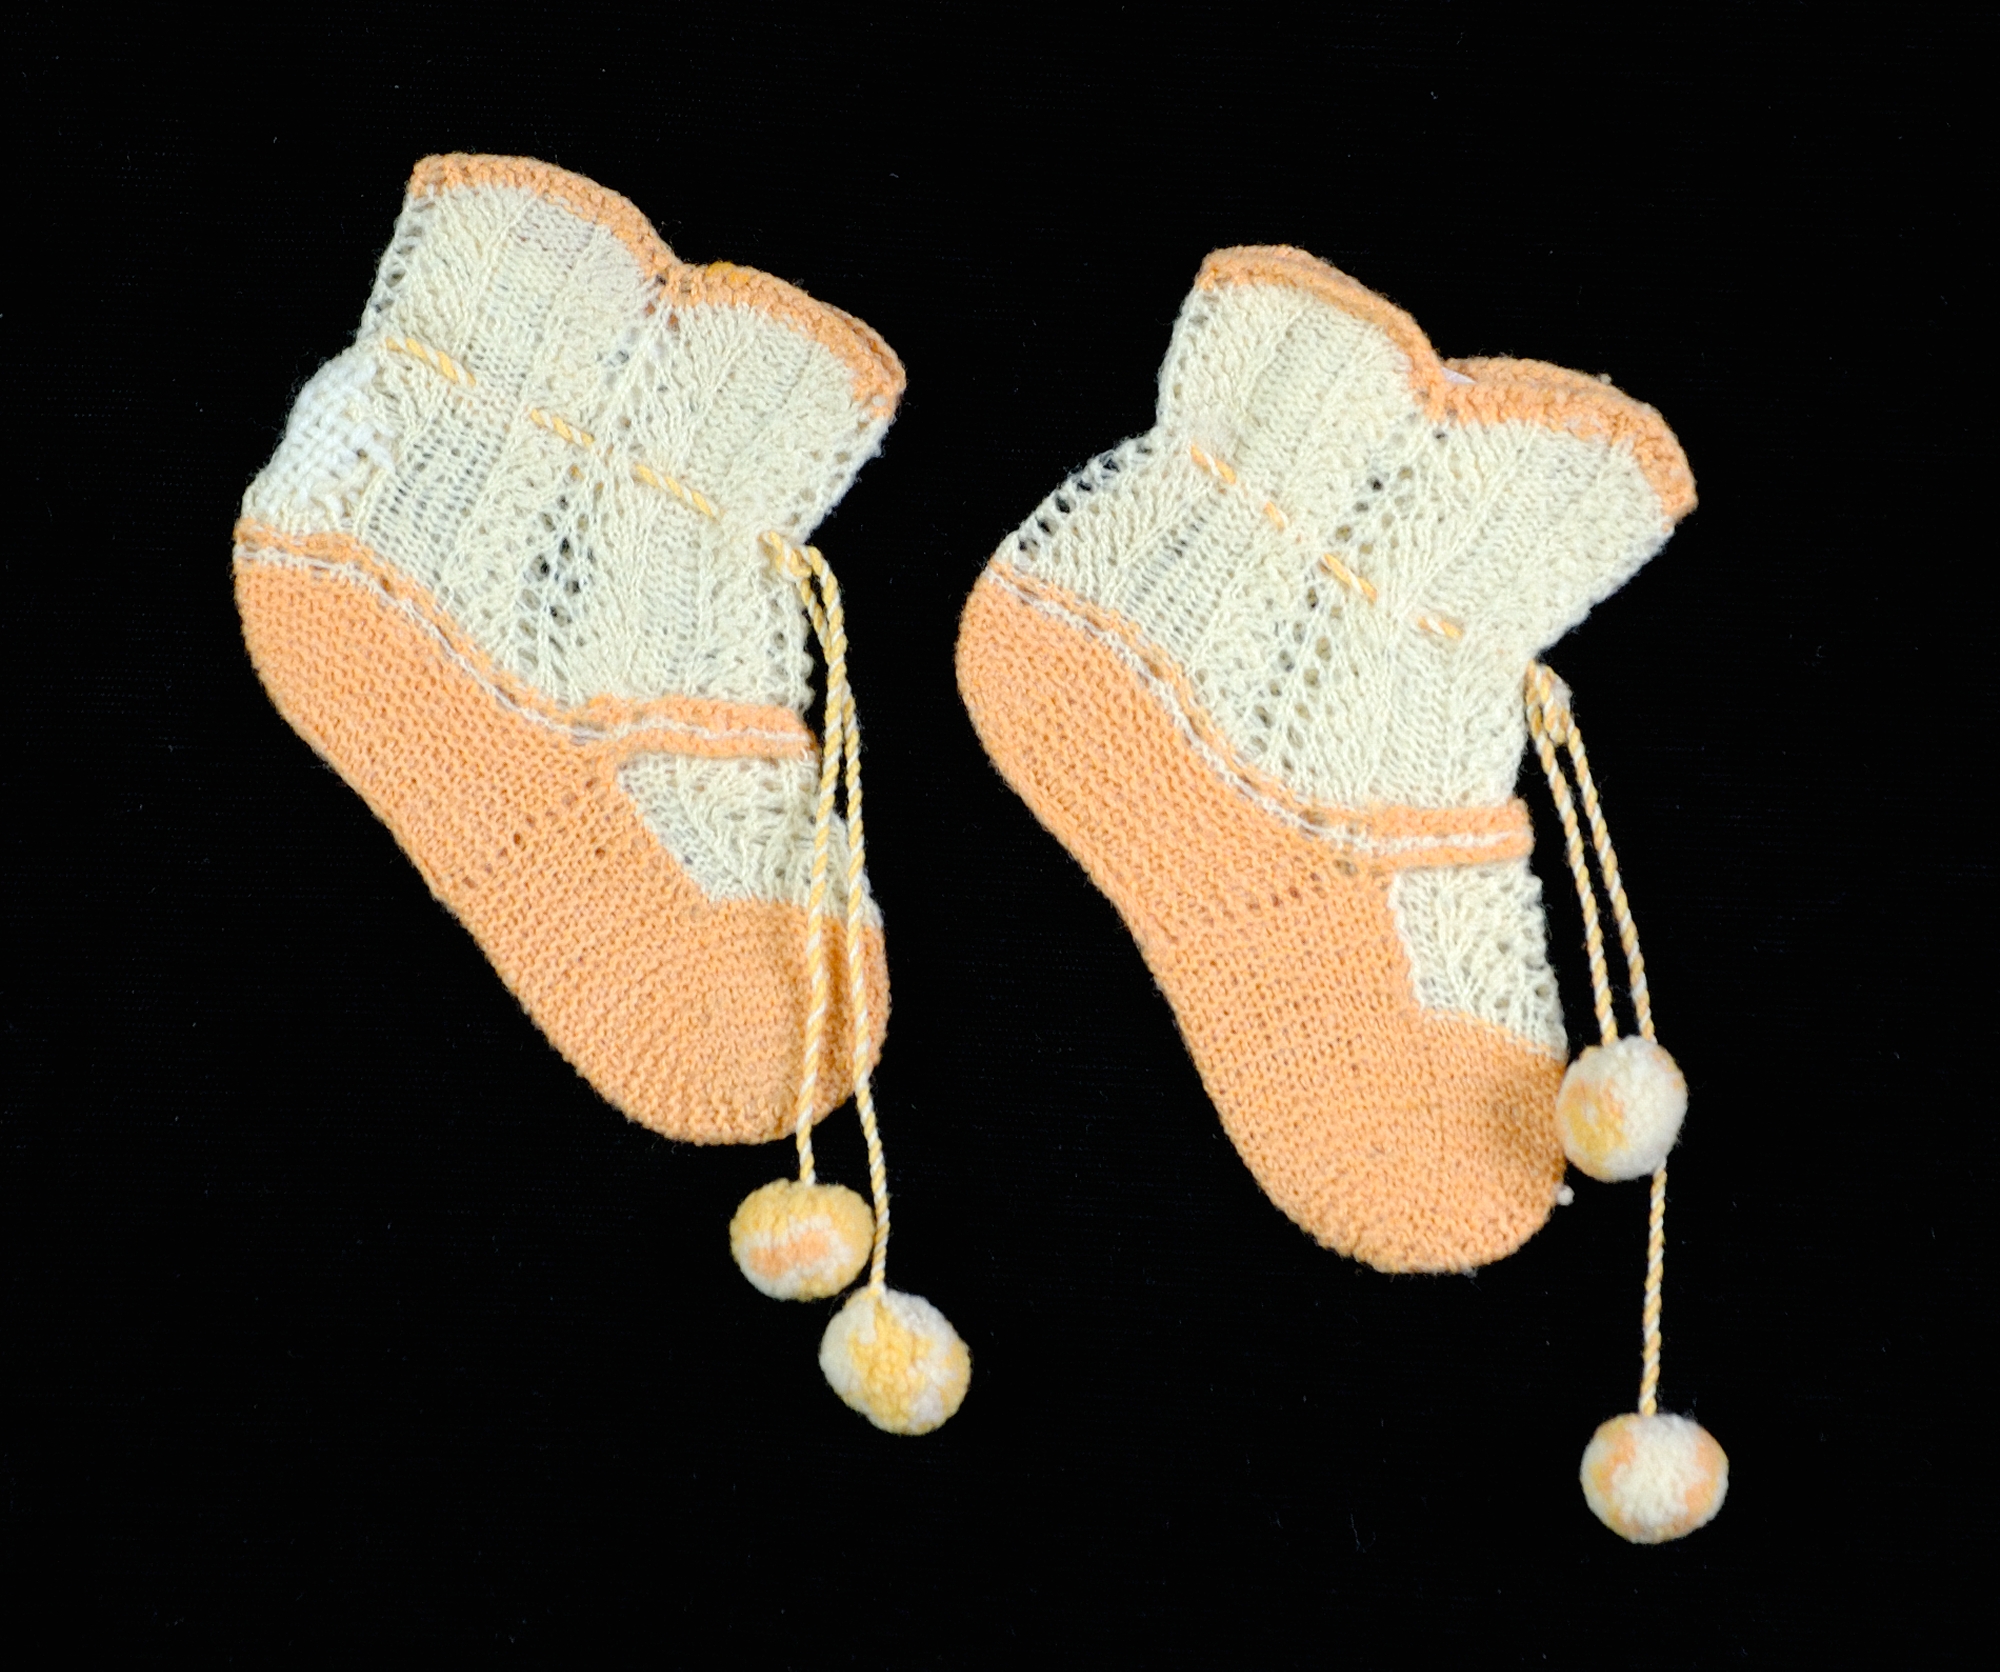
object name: bootee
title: Bootees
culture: american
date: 1840-1860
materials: wool